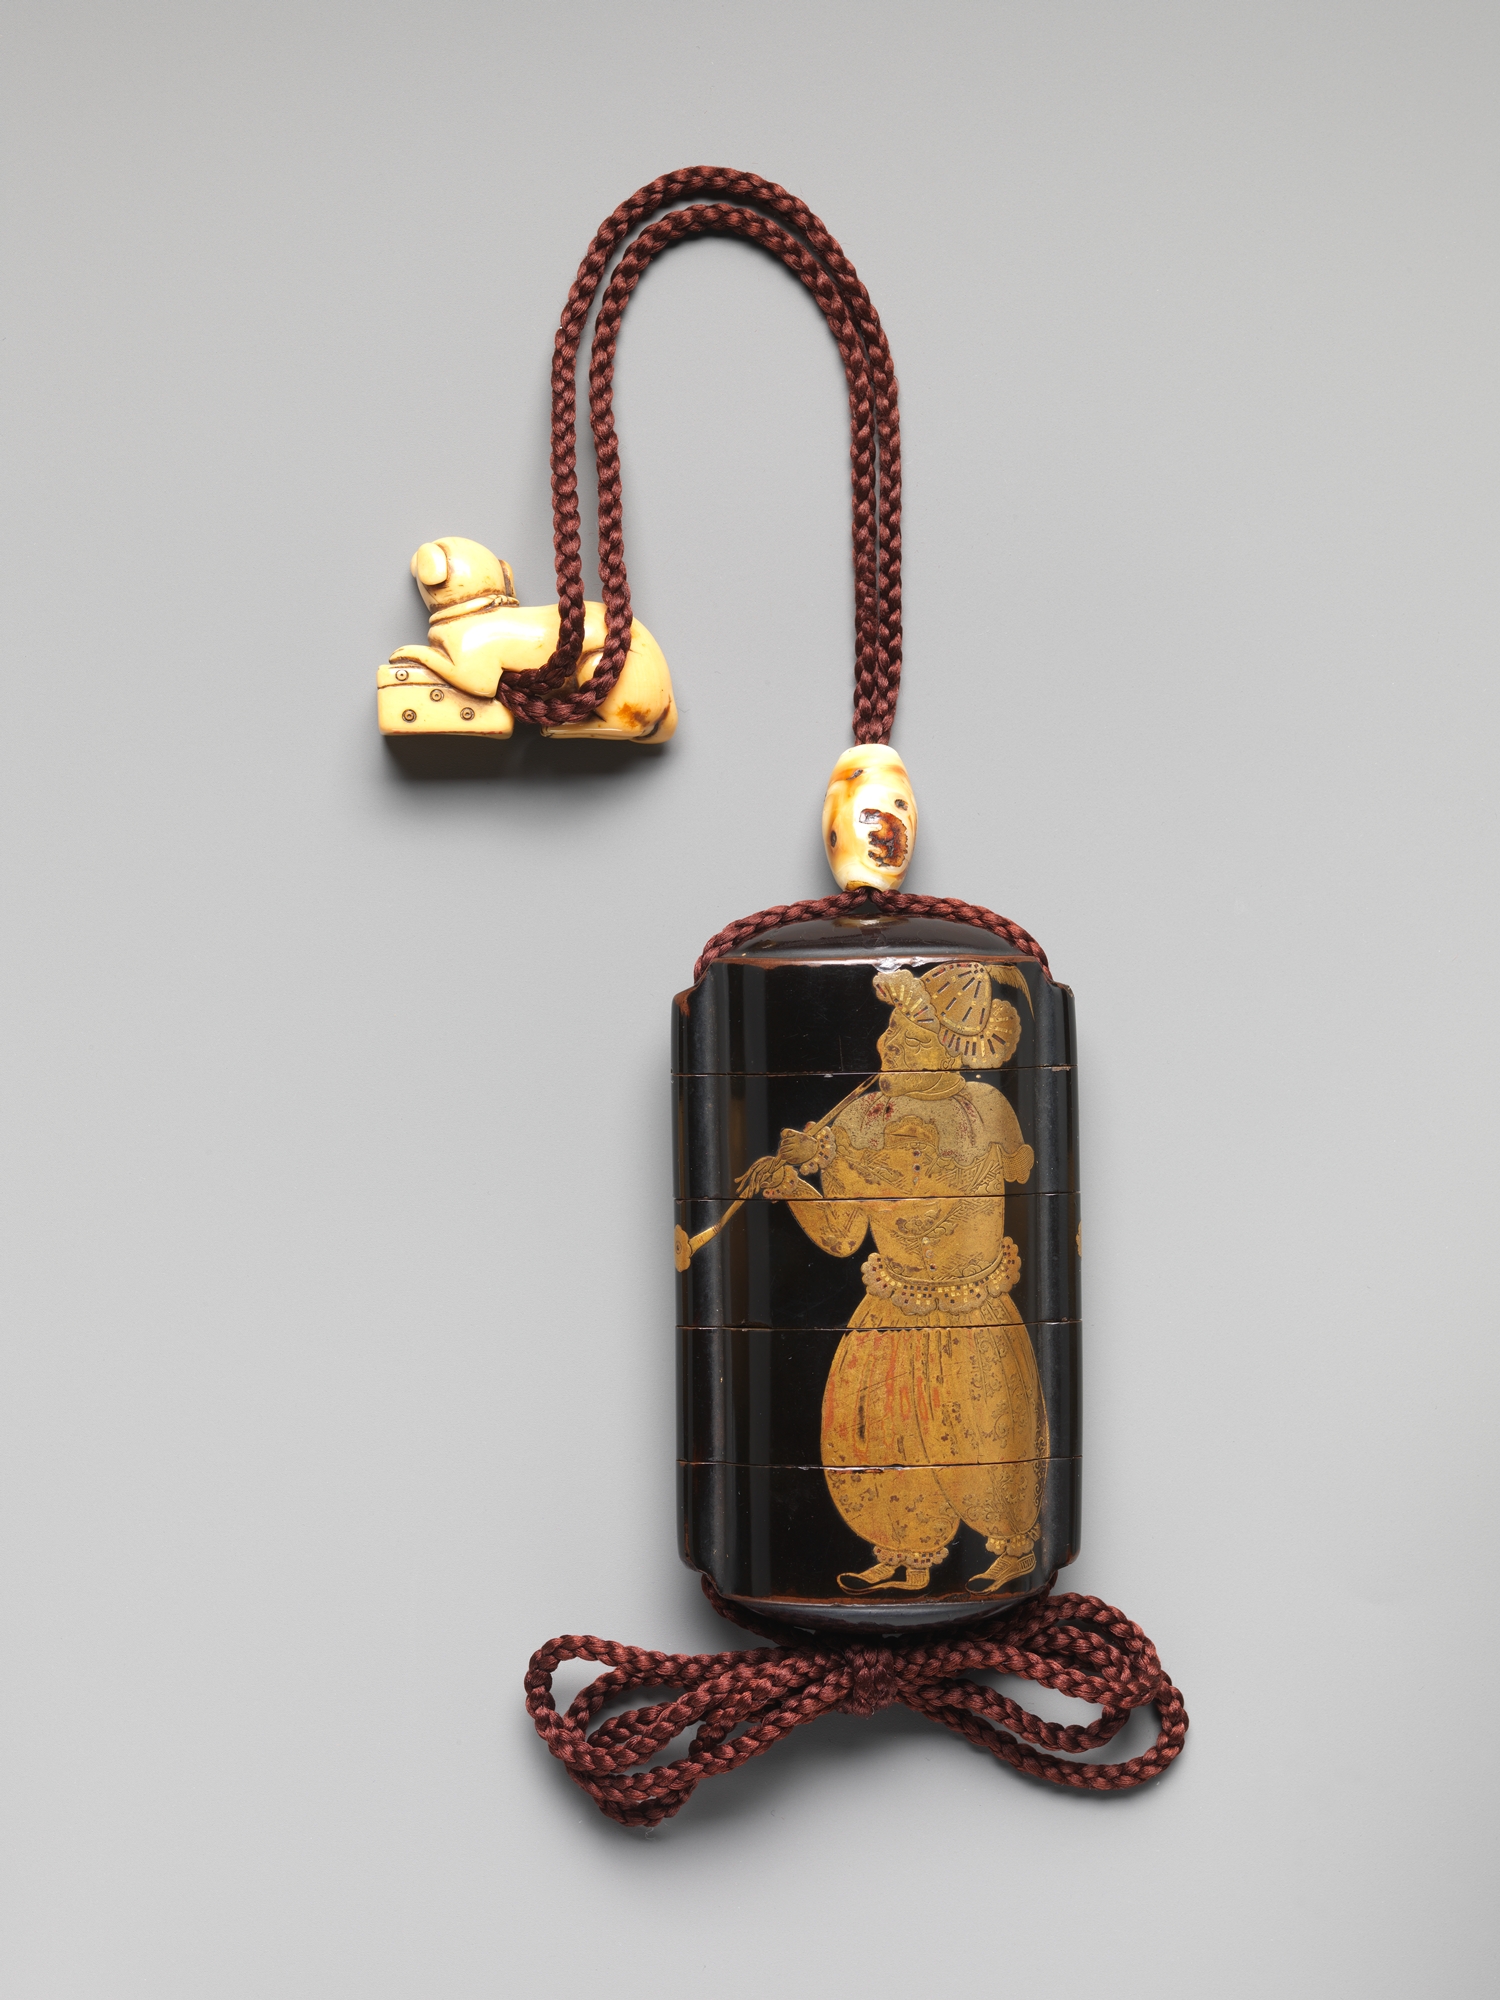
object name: inrō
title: Inrō with Portuguese Figures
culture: japanese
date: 1767-1833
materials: antler, gold, gold foil, ivory, wood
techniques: cutting, hiramakie, lacquer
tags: men,dogs